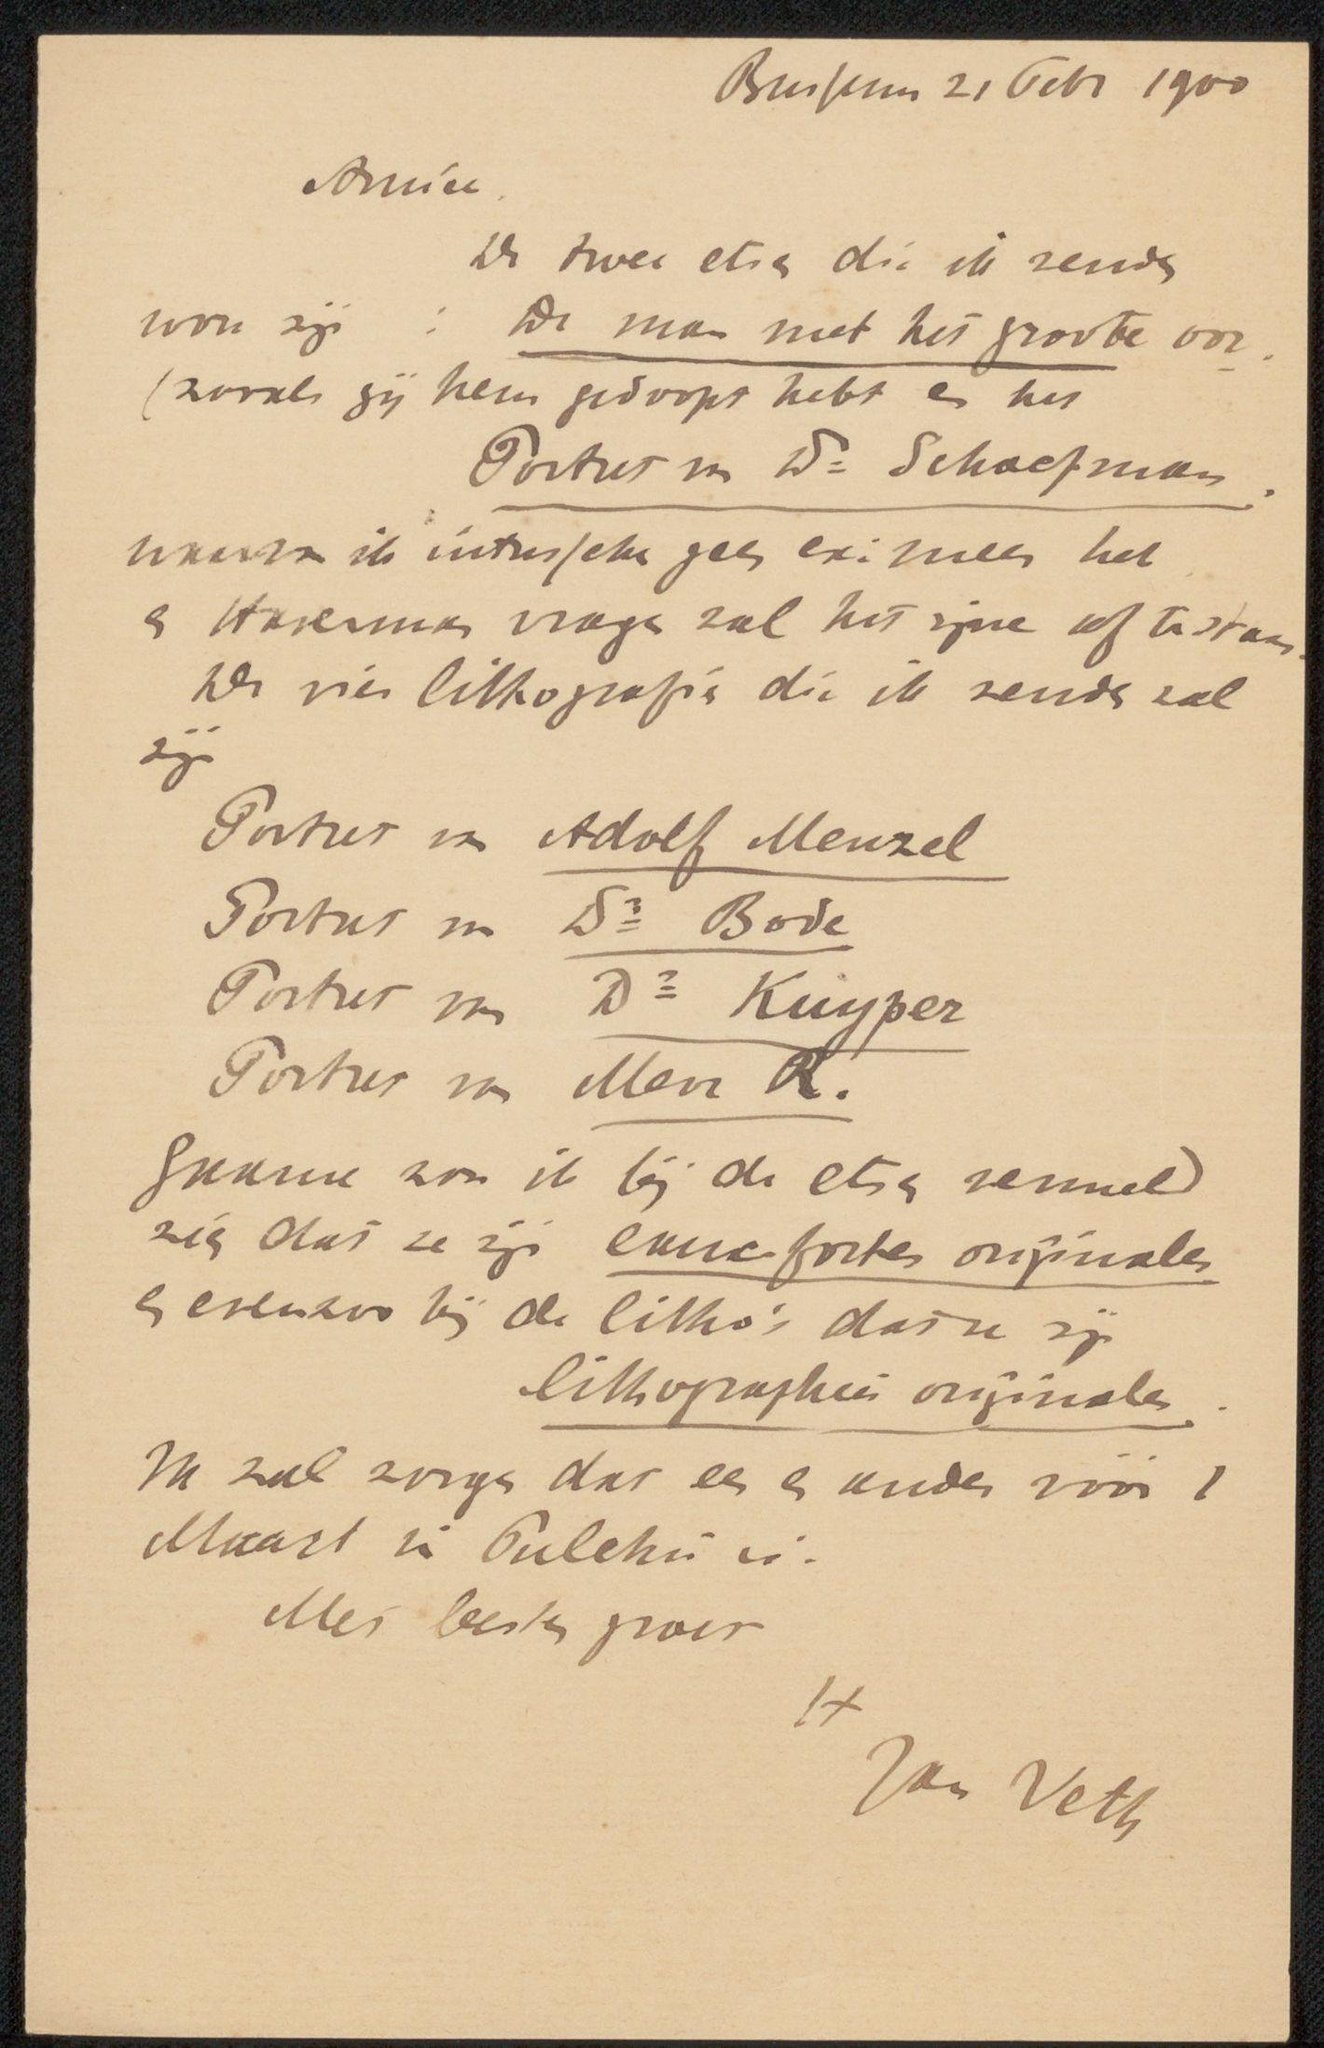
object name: letter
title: Brief aan Philip Zilcken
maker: jan veth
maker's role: designer, draughtsman, painter, print maker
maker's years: 1864-1925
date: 1900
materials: ink, paper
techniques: pen, writing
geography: bussum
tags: the hague, abraham kuyper, rome, priest, herman johannes aloysius maria schaepman, berlin, wilhelm von bode, philip zilcken, the graphic arts, historical persons (portraits and scenes from the life)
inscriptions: collector's mark: ‘RPK’, watermark